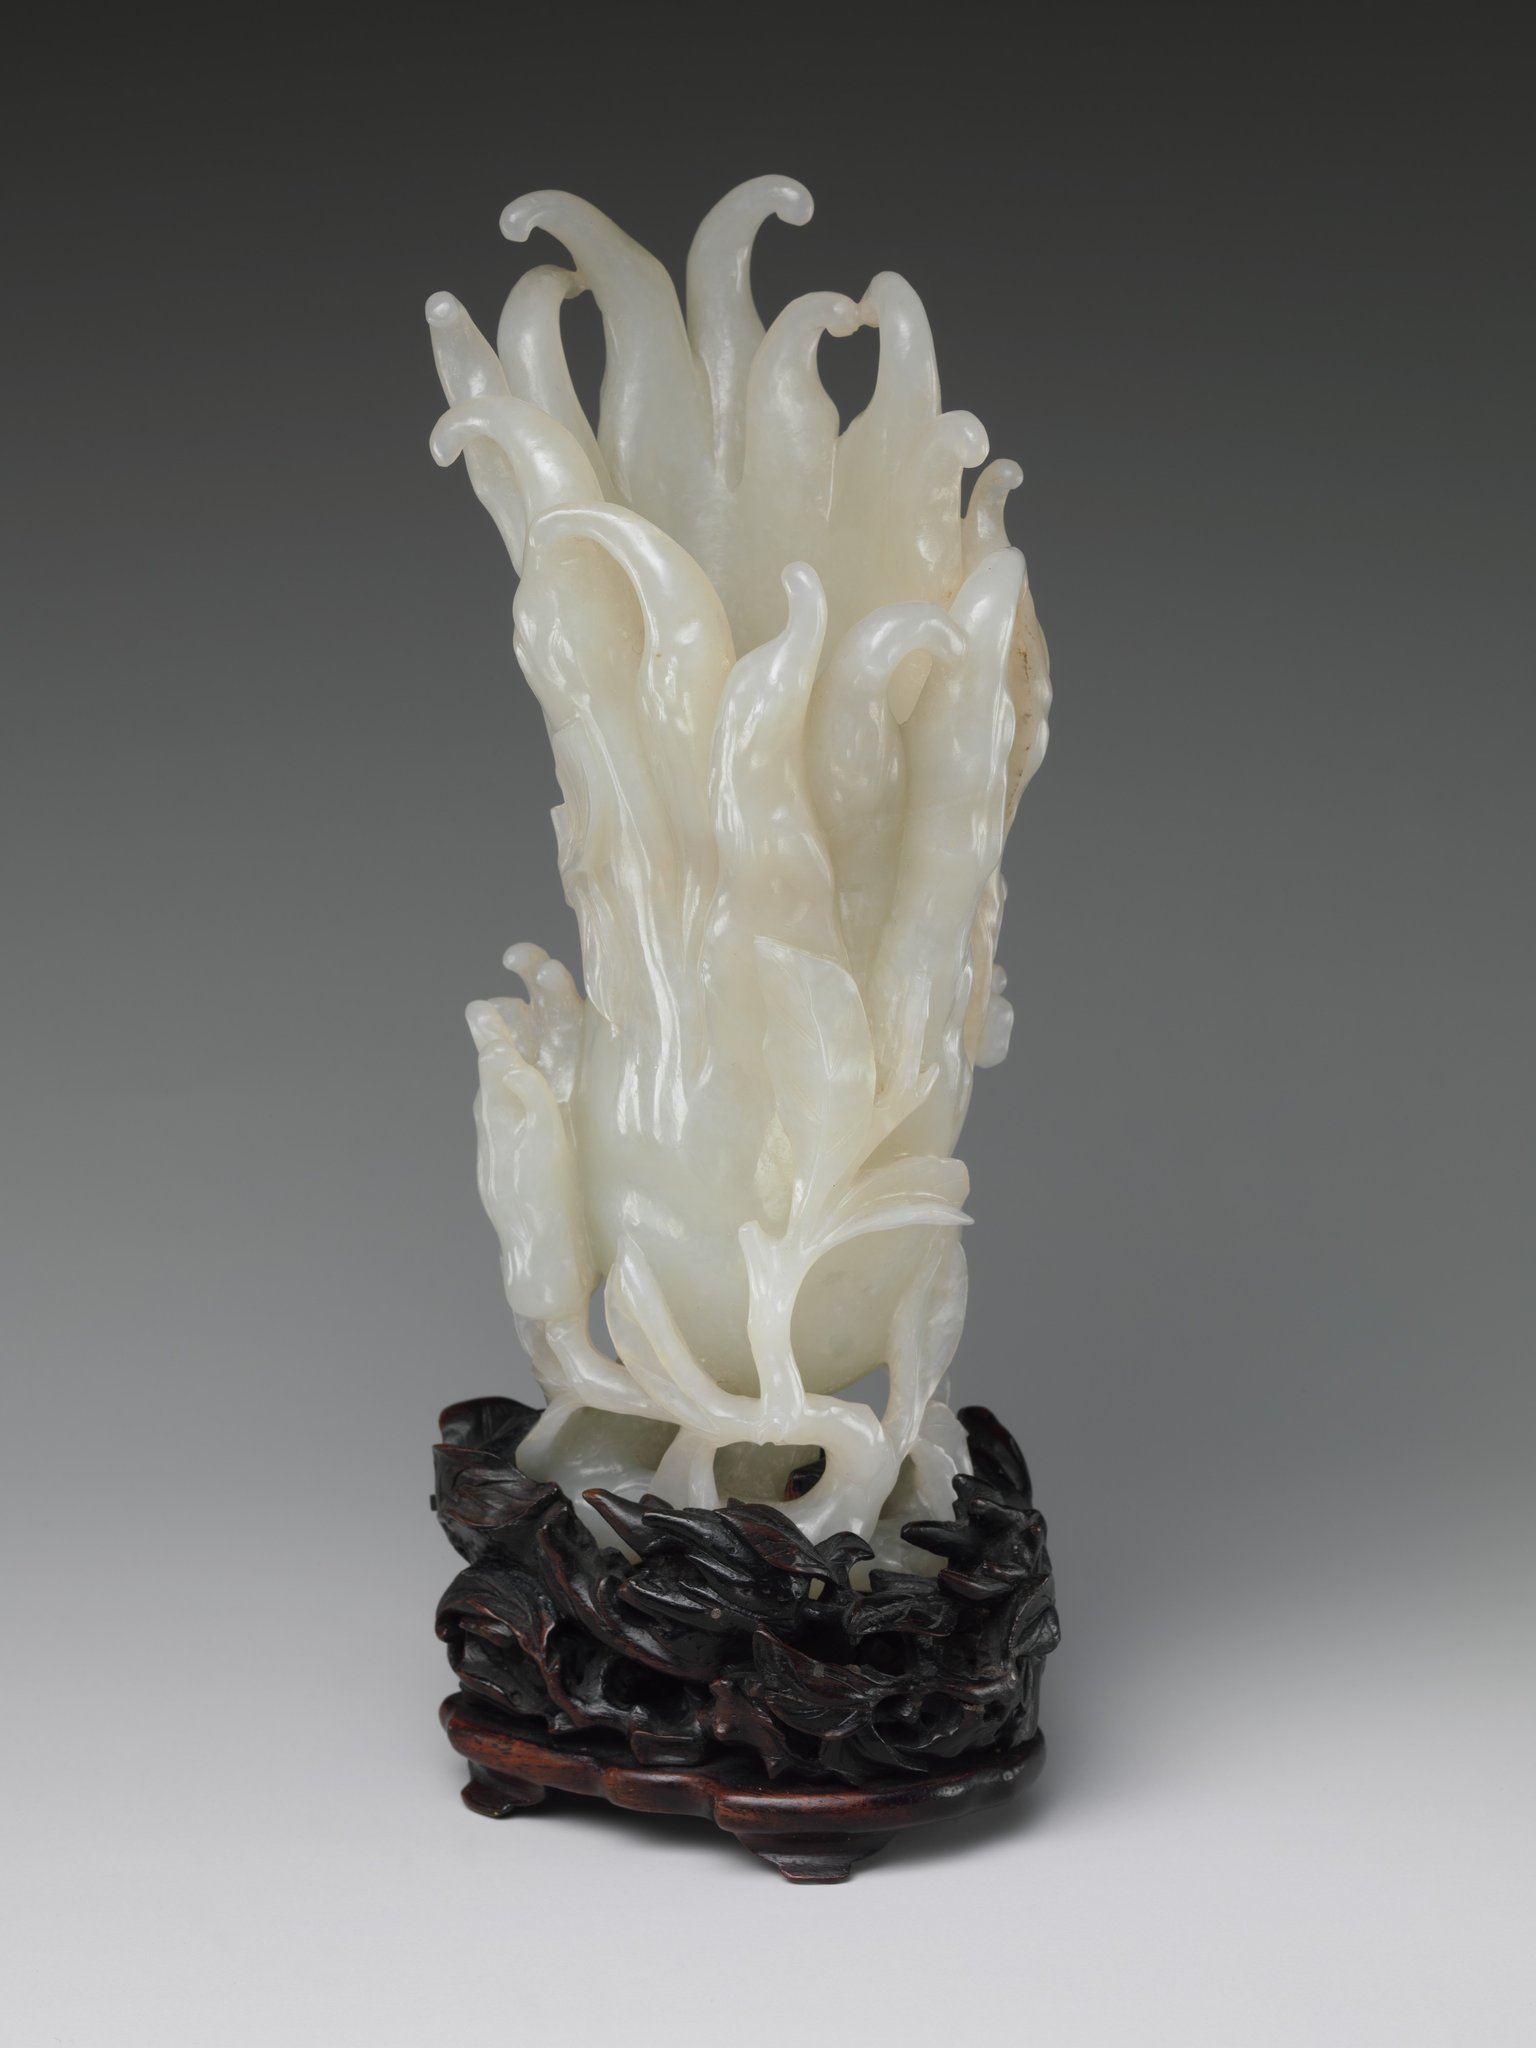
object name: vase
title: Buddha’s hand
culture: chinese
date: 1644-1911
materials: jade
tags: hands